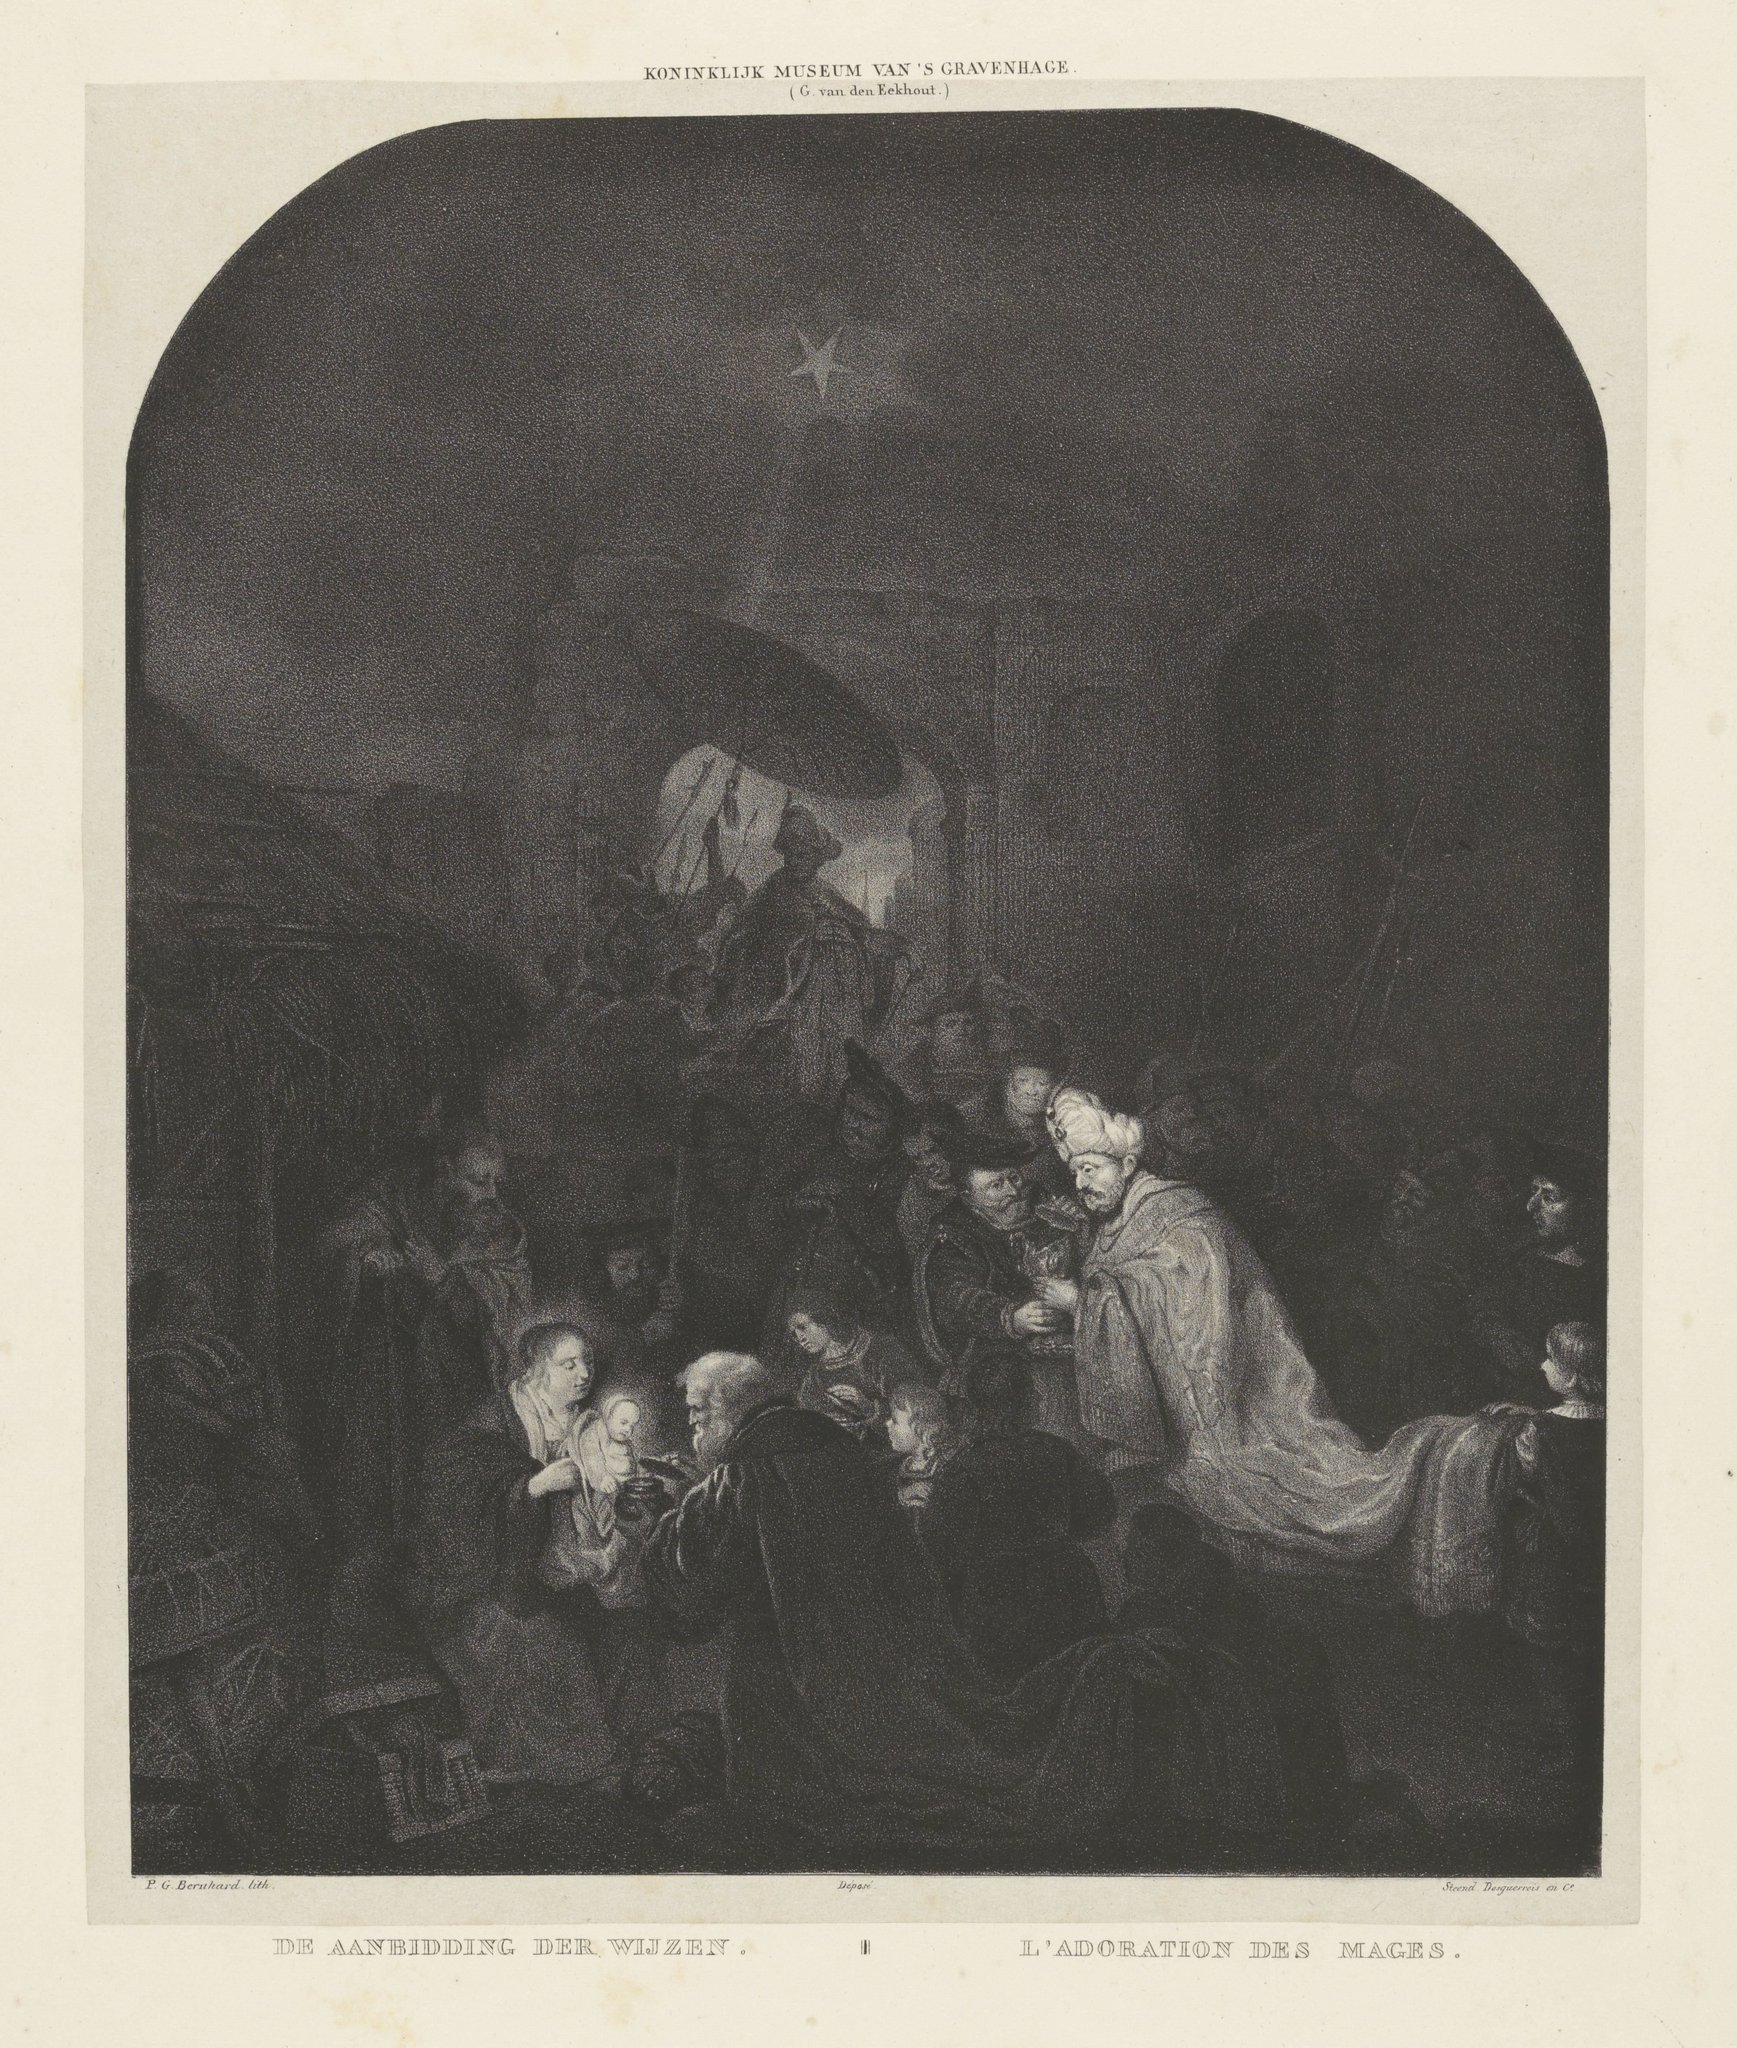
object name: print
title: Aanbidding der wijzen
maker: pieter gerardus bernhard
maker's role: print maker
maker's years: 1813-1880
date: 1823-1880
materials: paper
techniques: lithograph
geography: amsterdam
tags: adoration of the kings: the wise men present their gifts to the christ-child (gold, frankincense and myrrh)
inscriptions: collector's mark: Lugt 2228, : ‘Déposé’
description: Bij een stal met een dak van stro zit Maria met Christus op schoot, bij hen de drie wijzen met hun geschenken. Om hen heen hebben zich veel figuren verzameld. In de hemel staat de ster. In de donkere achtergrond van het nachtelijke tafereel is een ruïne te zien. Naar een schilderij van Salomon Koninck.